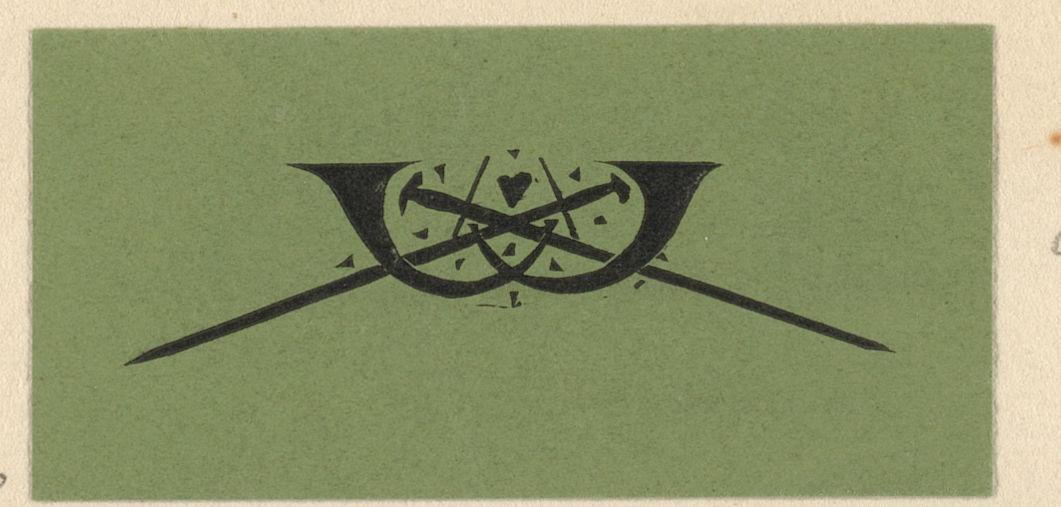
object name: book illustration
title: Sluitvignet met jachthoorns en lansen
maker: gerrit willem dijsselhof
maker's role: designer, draughtsman, print maker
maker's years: 1866-1924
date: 1893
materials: paper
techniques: galvanoplasty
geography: haarlem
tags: horn, trumpet, cornet, trombone, tuba, helved weapons, polearms (for striking, hacking, thrusting): lance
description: Sluitvignet gebruikt in: Crane, Walter. Kunst en samenleving. [Vertaald uit het Engels door] Jan Veth. Amsterdam: Scheltema & Holkema's Boekhandel, 1894 [1893], p. 81. Later zijn deze afbeeldingen door de uitgever veelvuldig gebruikt voor andere uitgaven. Zie bijvoorbeeld RP-P-1969-415, een catalogus van de in 1894 bij Scheltema & Holkema's Boekhandel verkrijgbare publicaties.